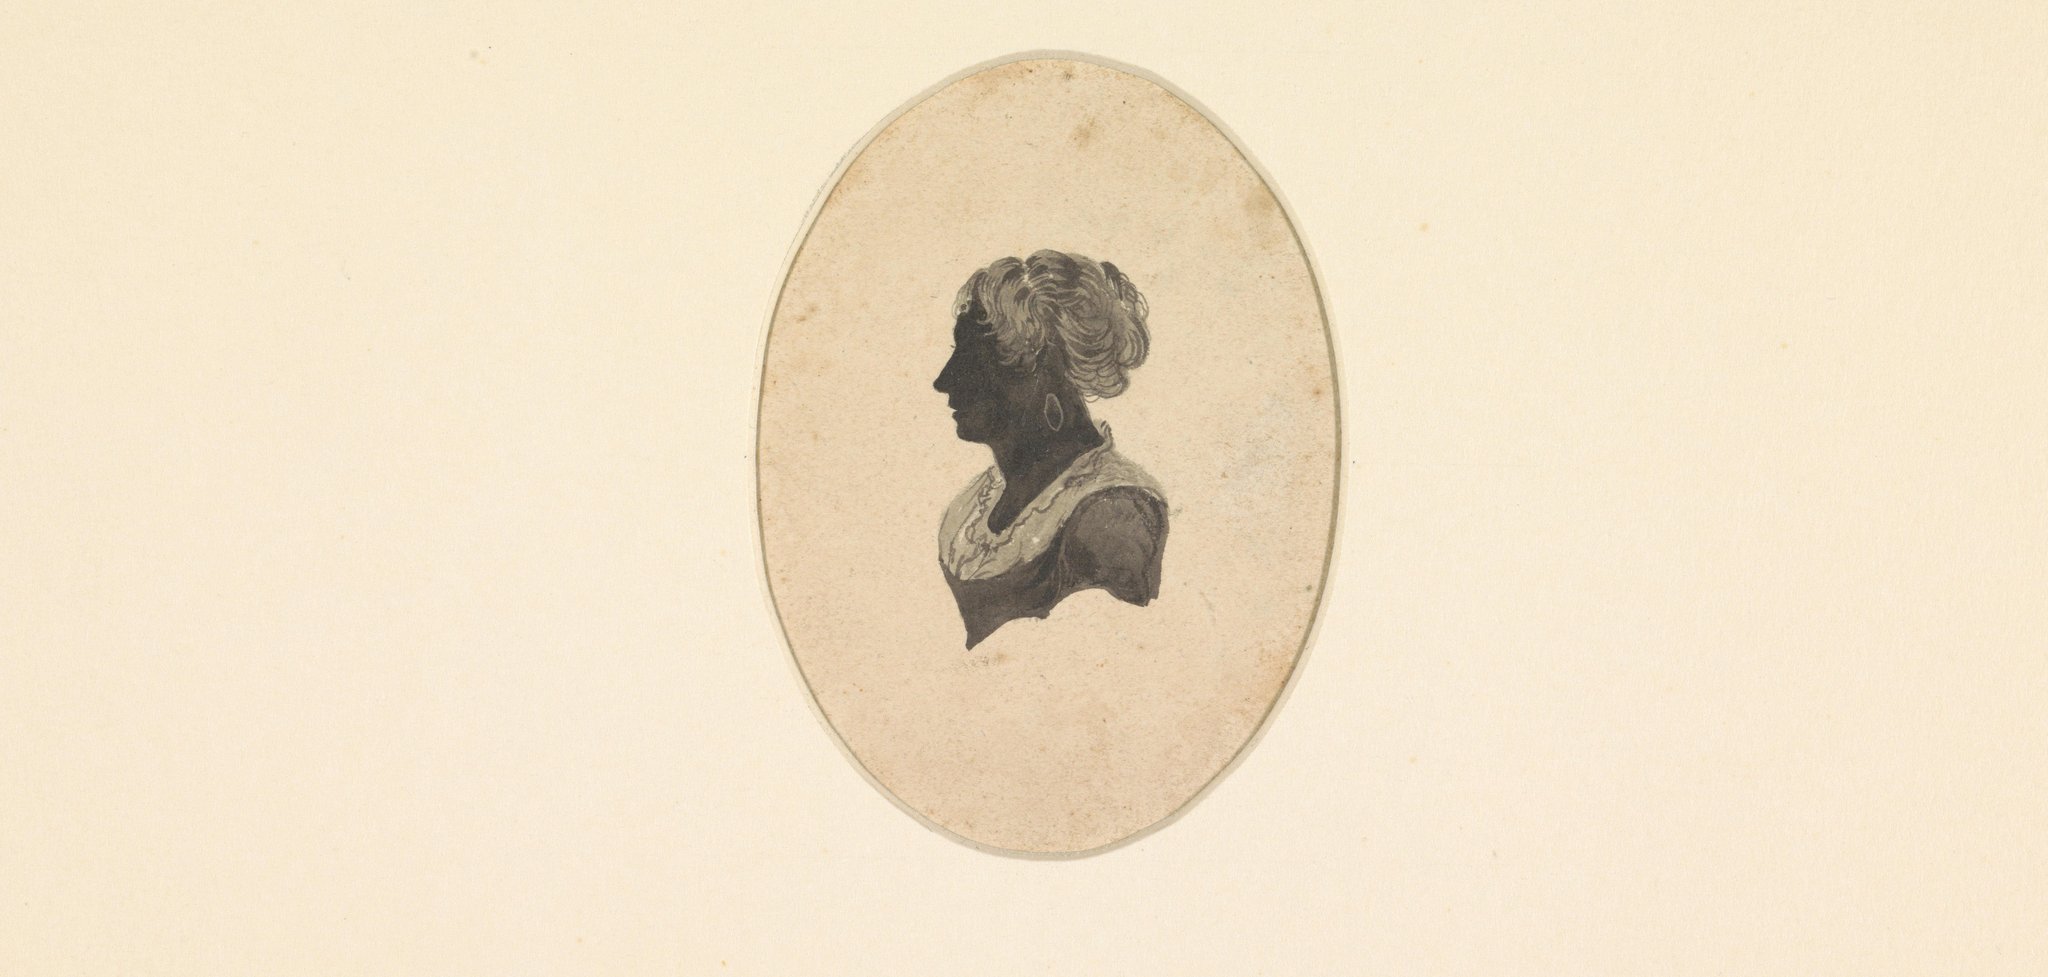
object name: drawing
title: Silhouet van een dame naar links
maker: Anonymous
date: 1800-1900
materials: paper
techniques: brush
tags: anonymous historical person portrayed alone, female sex; woman